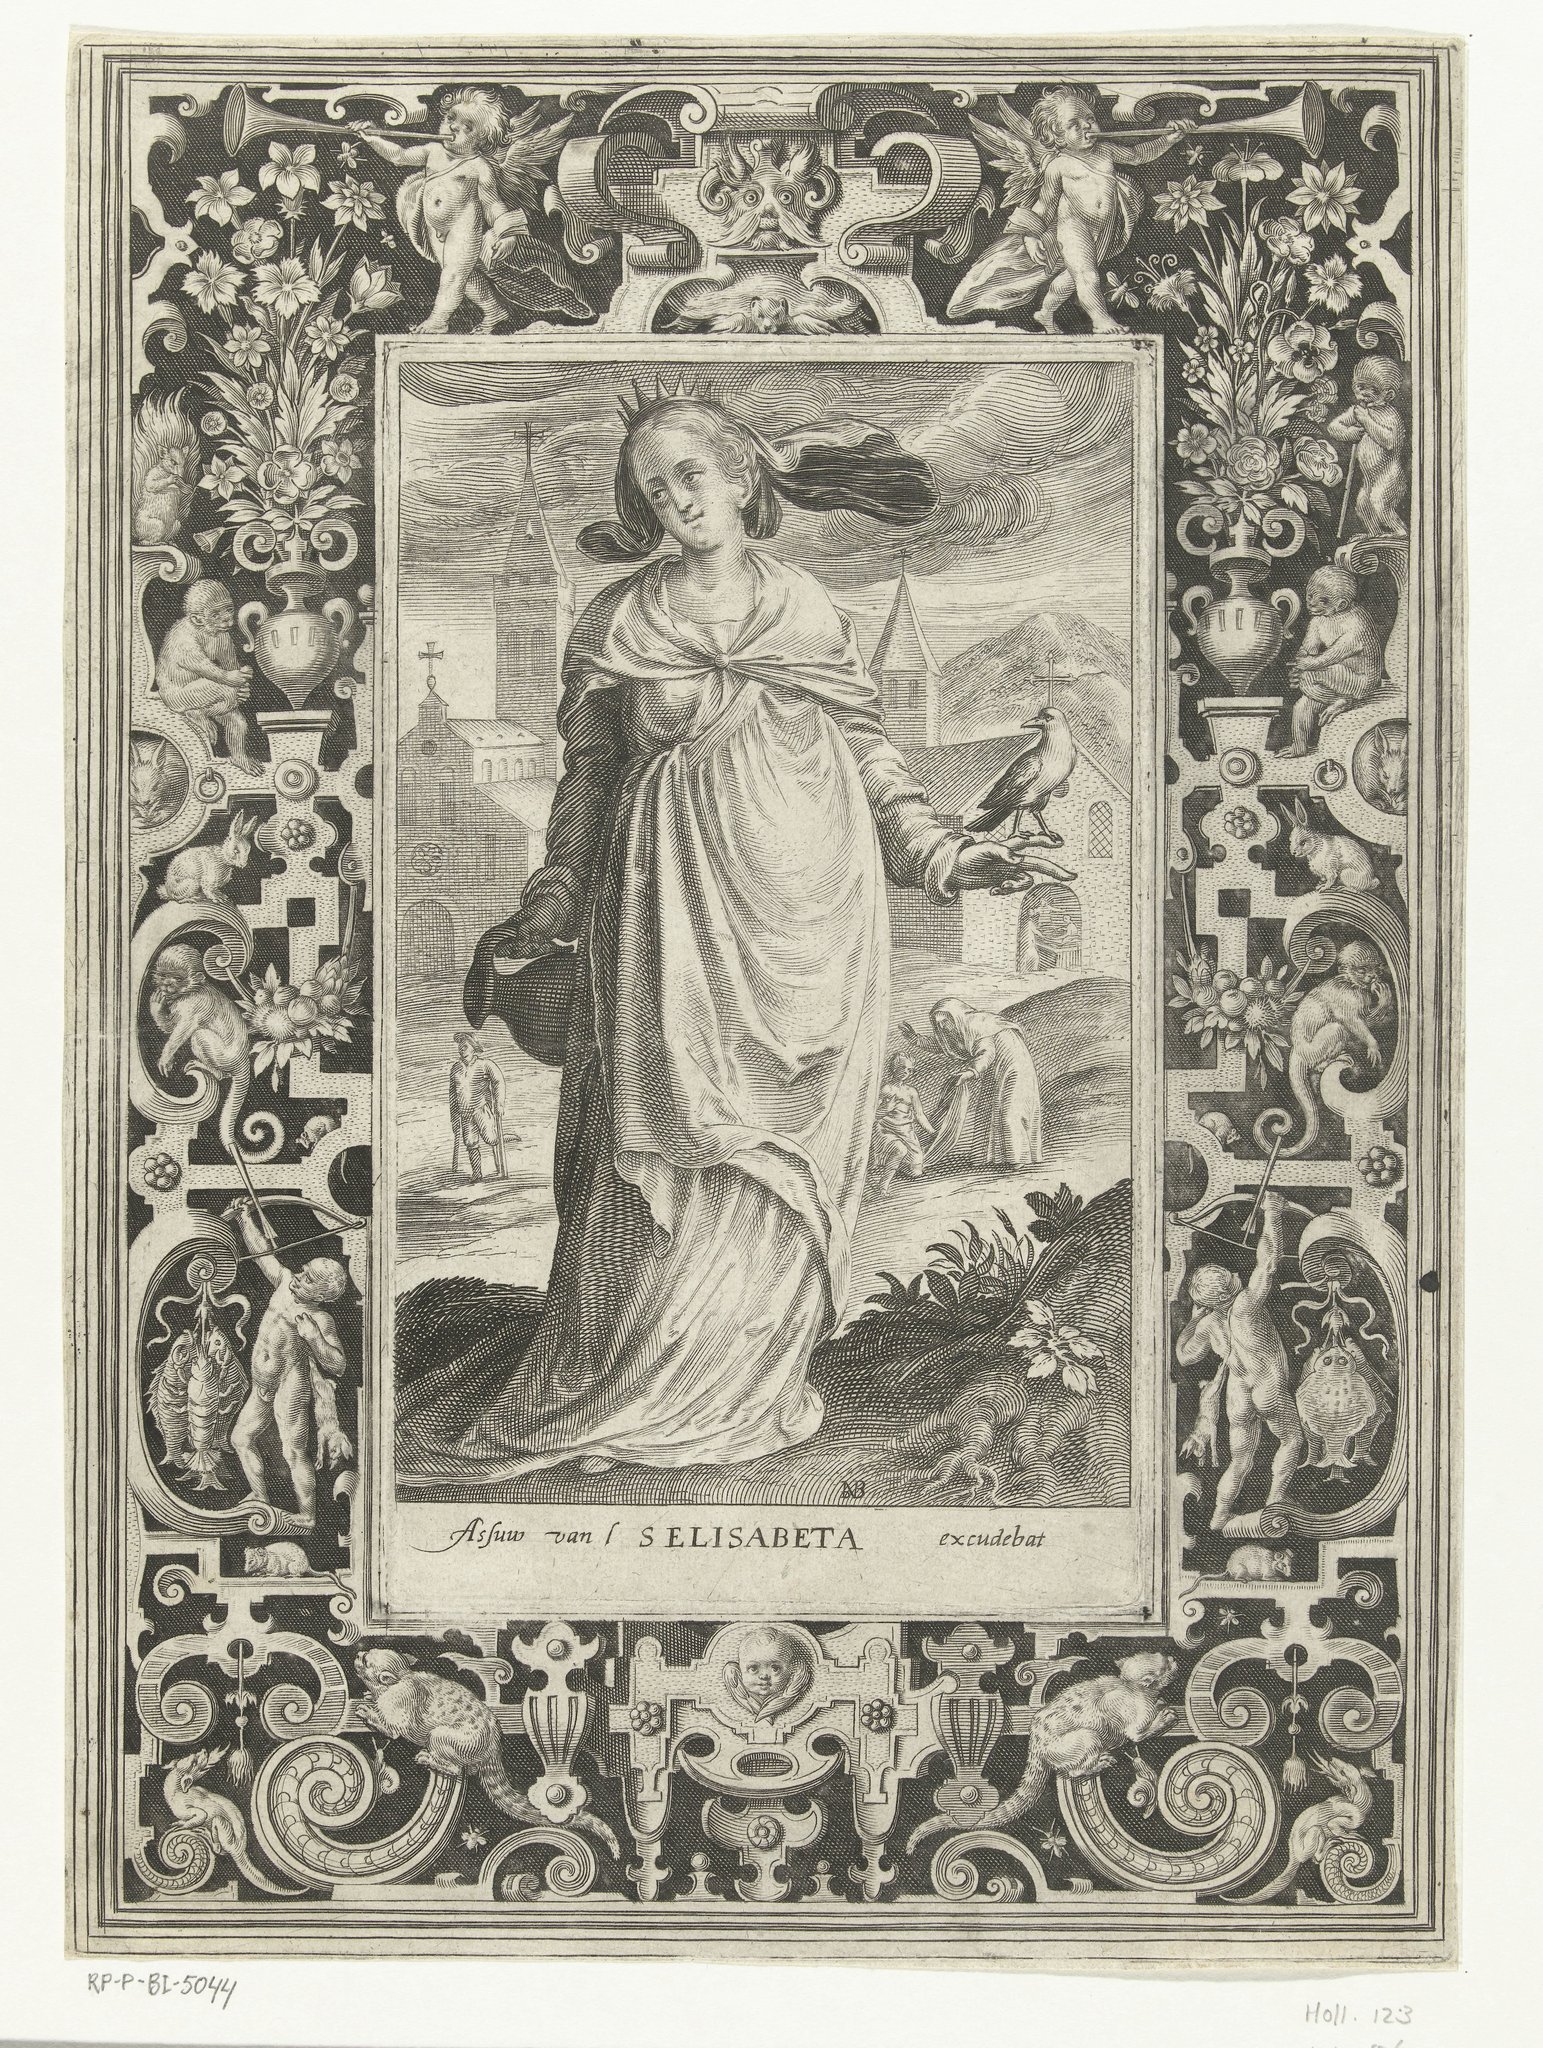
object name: print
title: Heldinnen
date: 1581-1656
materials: paper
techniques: engraving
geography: netherlands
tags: elisabeth, mother of john the baptist; possible attributes: john the baptist as child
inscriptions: collector's mark: Lugt 2228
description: Prent maakt mogelijk deel uit van een serie prenten met heldinnen welke allemaal een omlijsting met ornamenten hebben die met een aparte plaat gedrukt zijn. De omlijsting bestaat in twee varianten welke bovendien gebruikt zijn voor de serie de negen besten.